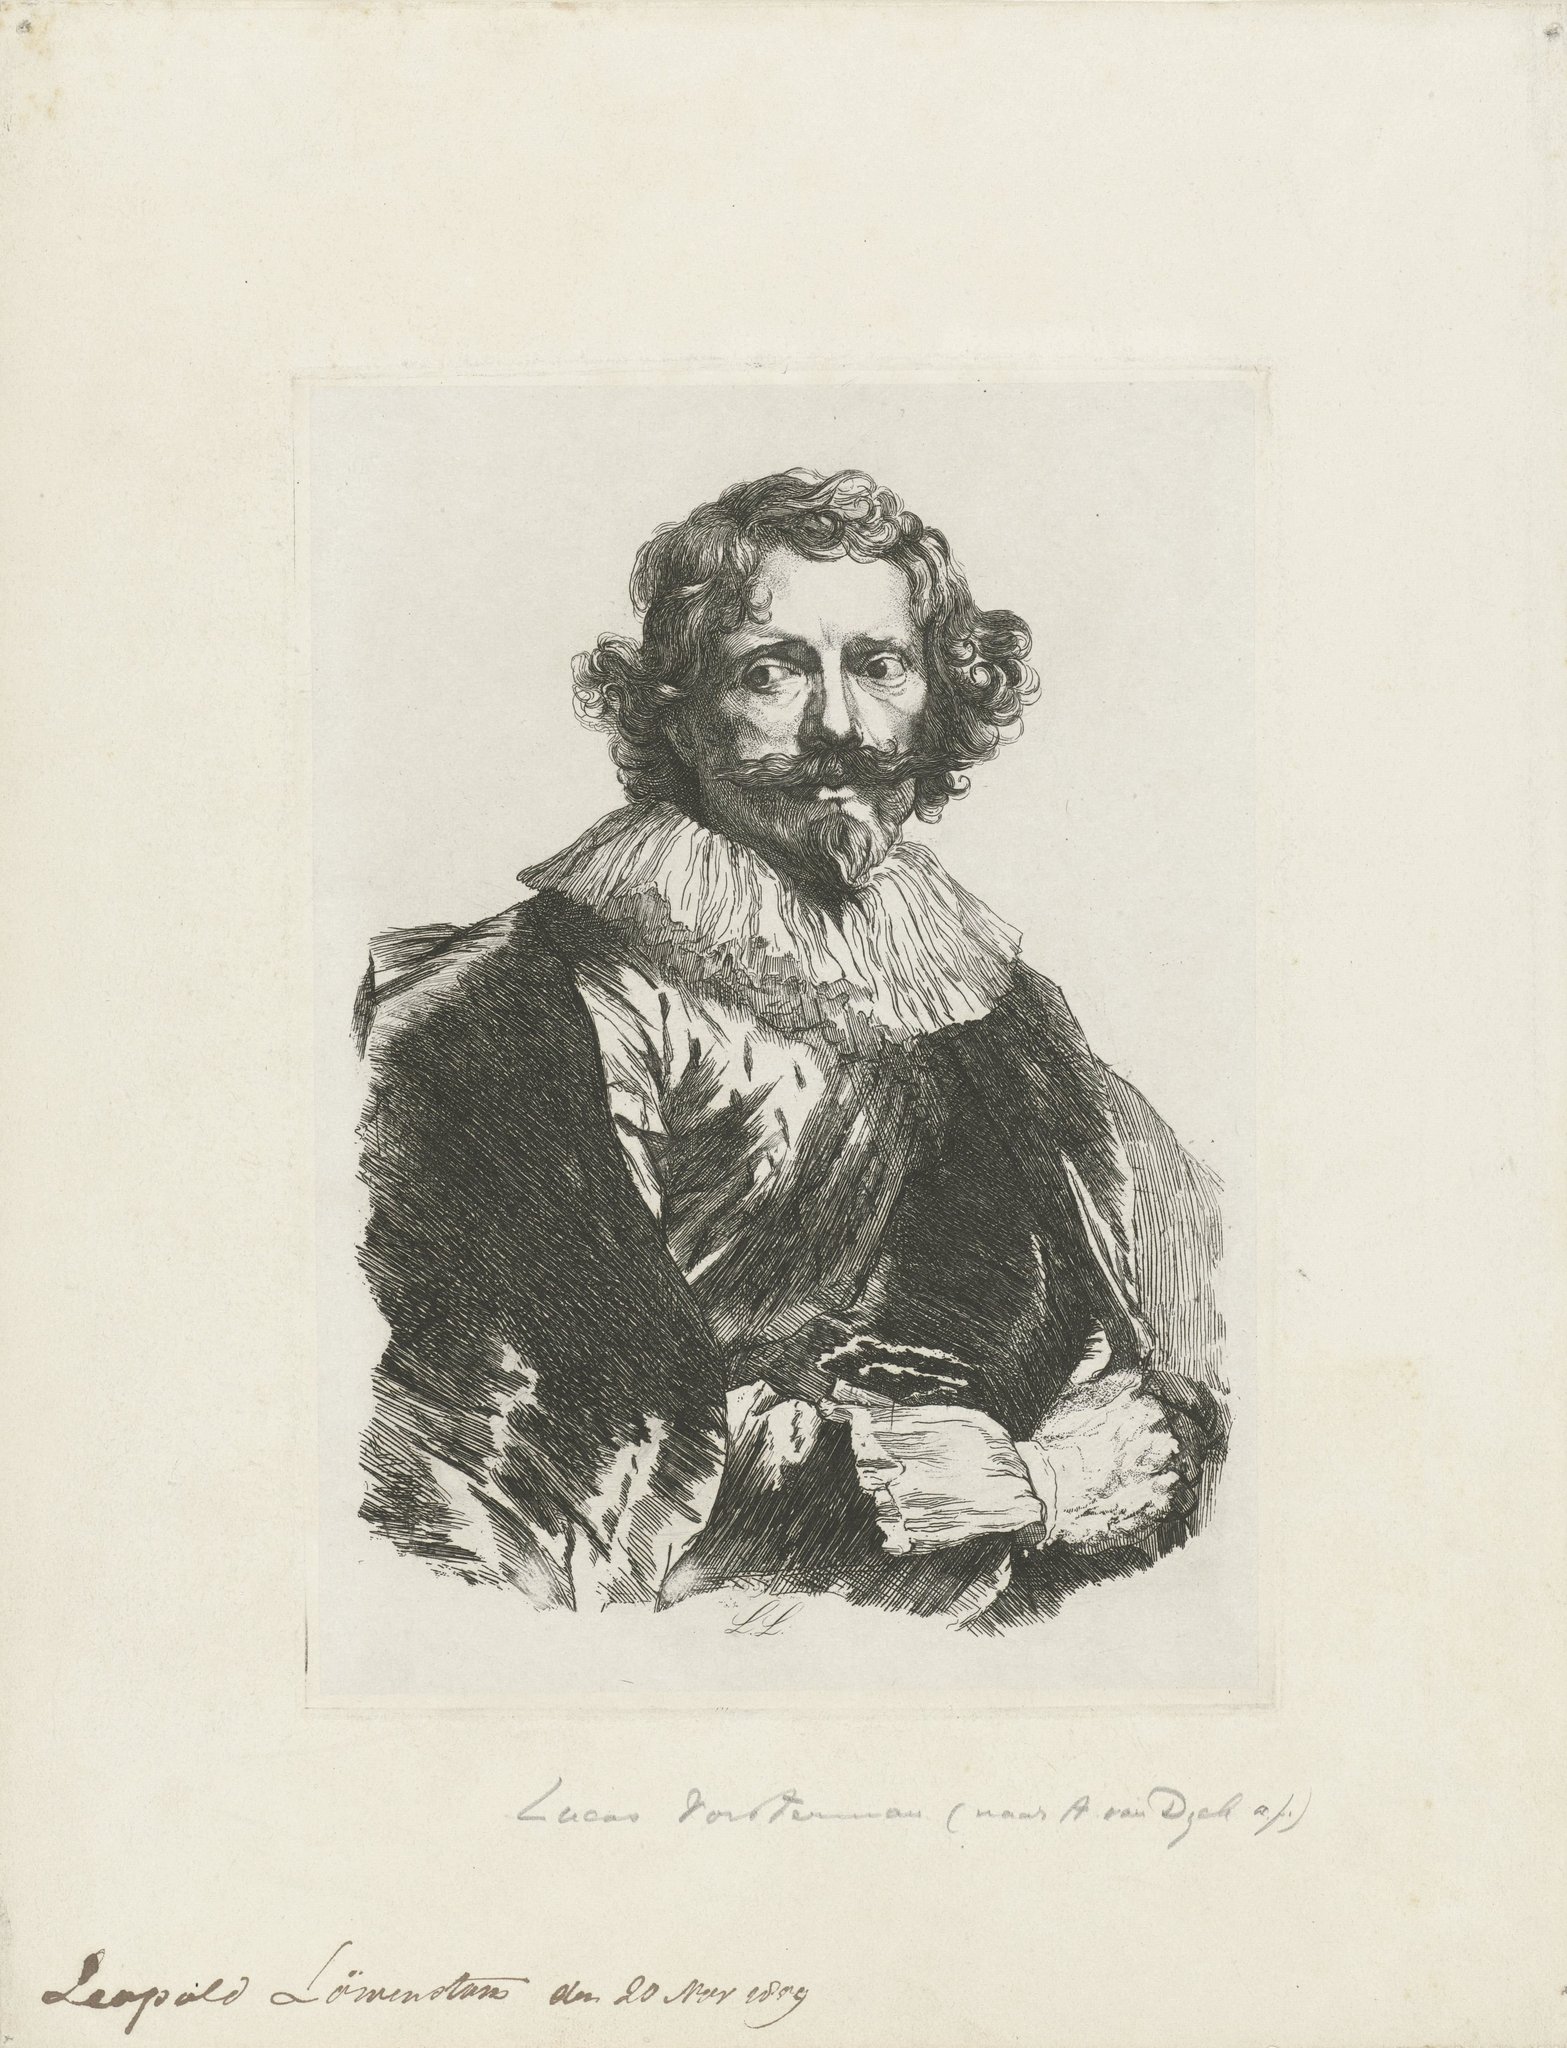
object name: print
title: Portret van Lucas Vorsterman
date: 1852-1898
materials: paper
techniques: etching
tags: antwerp, print maker, lucas vorsterman (i)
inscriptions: collector's mark: Lugt 2228, inscription: ‘Leopold Löwenstam den 20 Nov 1859’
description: Portret van Lucas Vorsterman, schilder en graveur.